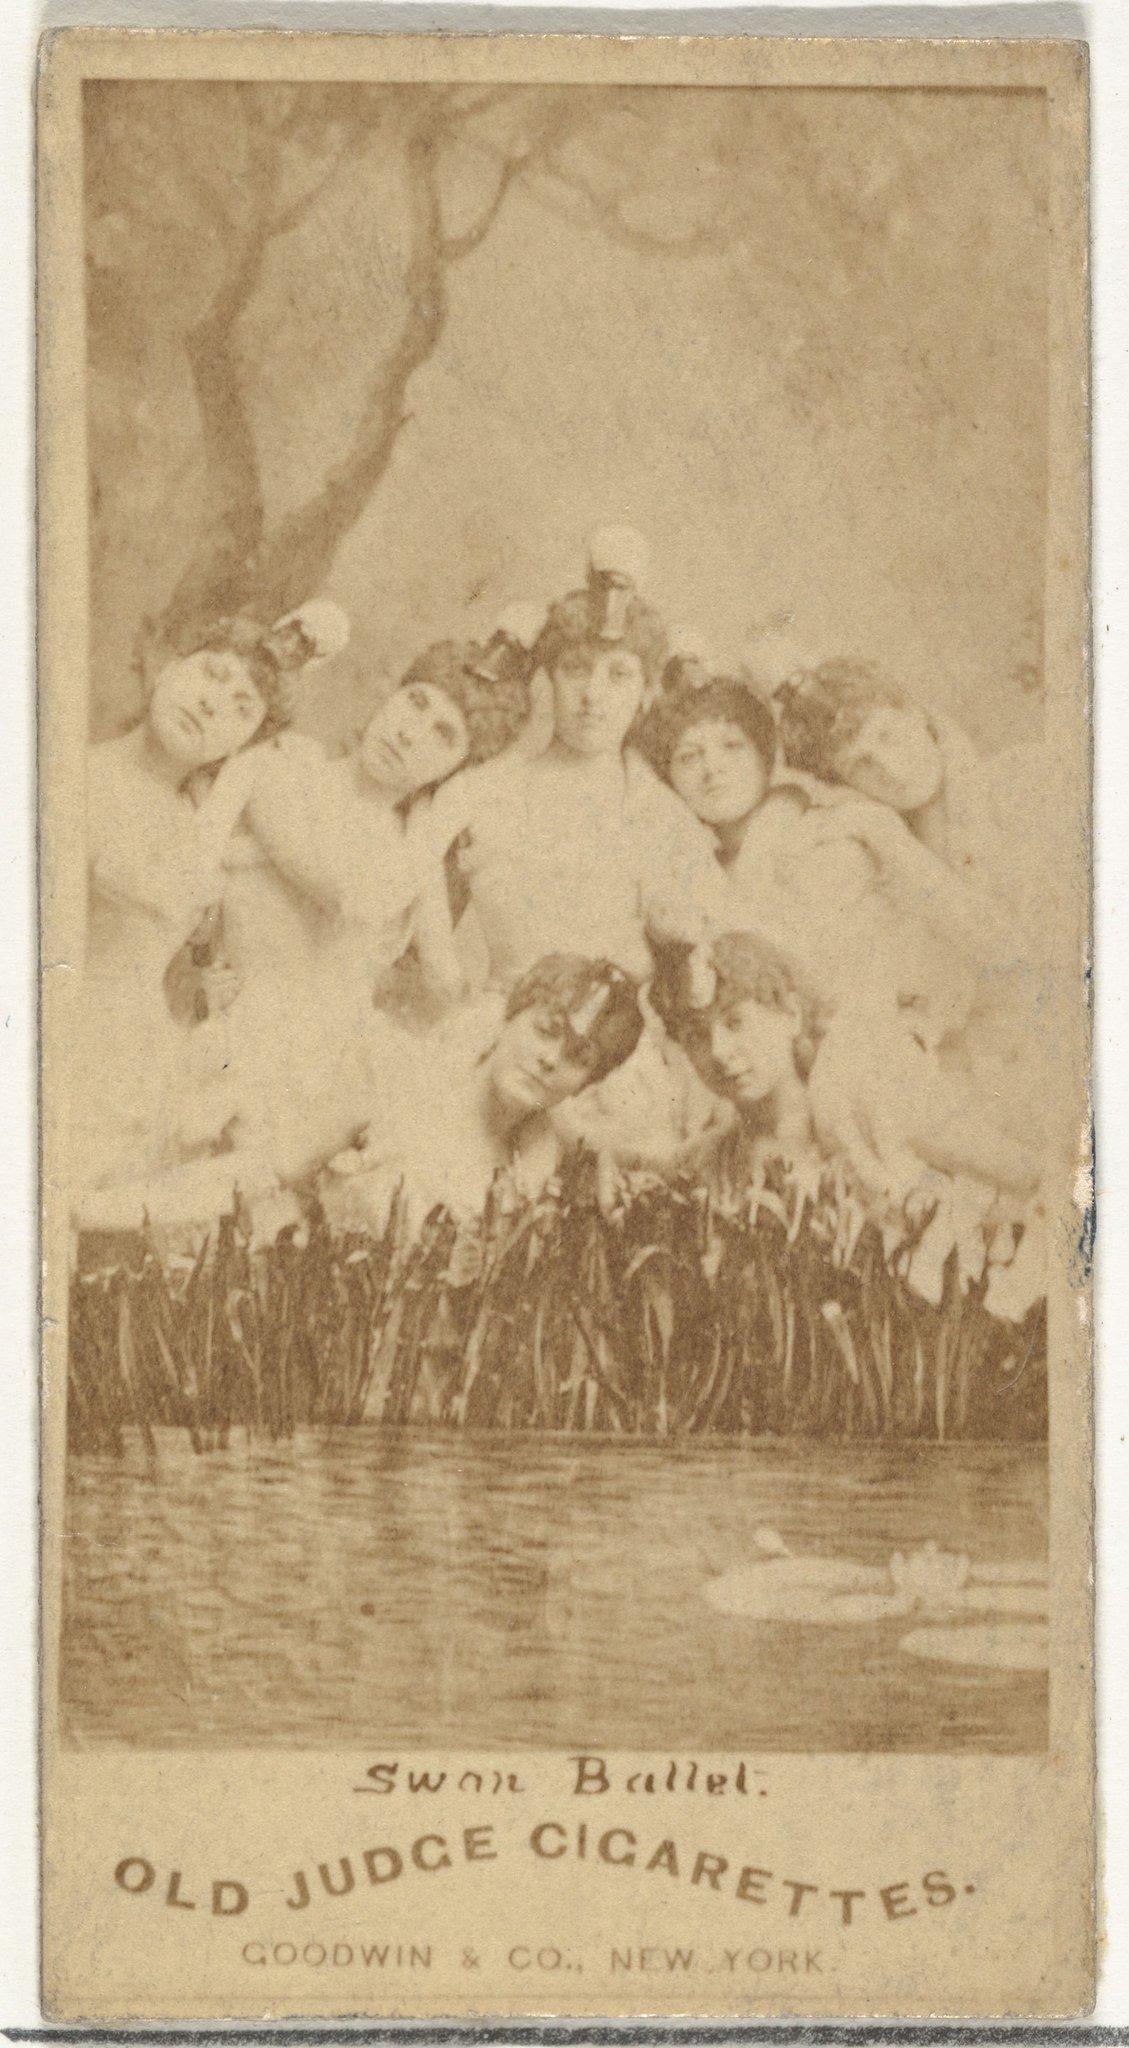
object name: photograph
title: Swan Ballet, from the Actors and Actresses series (N171) for Old Judge Cigarettes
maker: goodwin & company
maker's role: publisher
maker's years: 1850-1950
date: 1886-1890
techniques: albumen silver print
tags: portraits,women,ballet